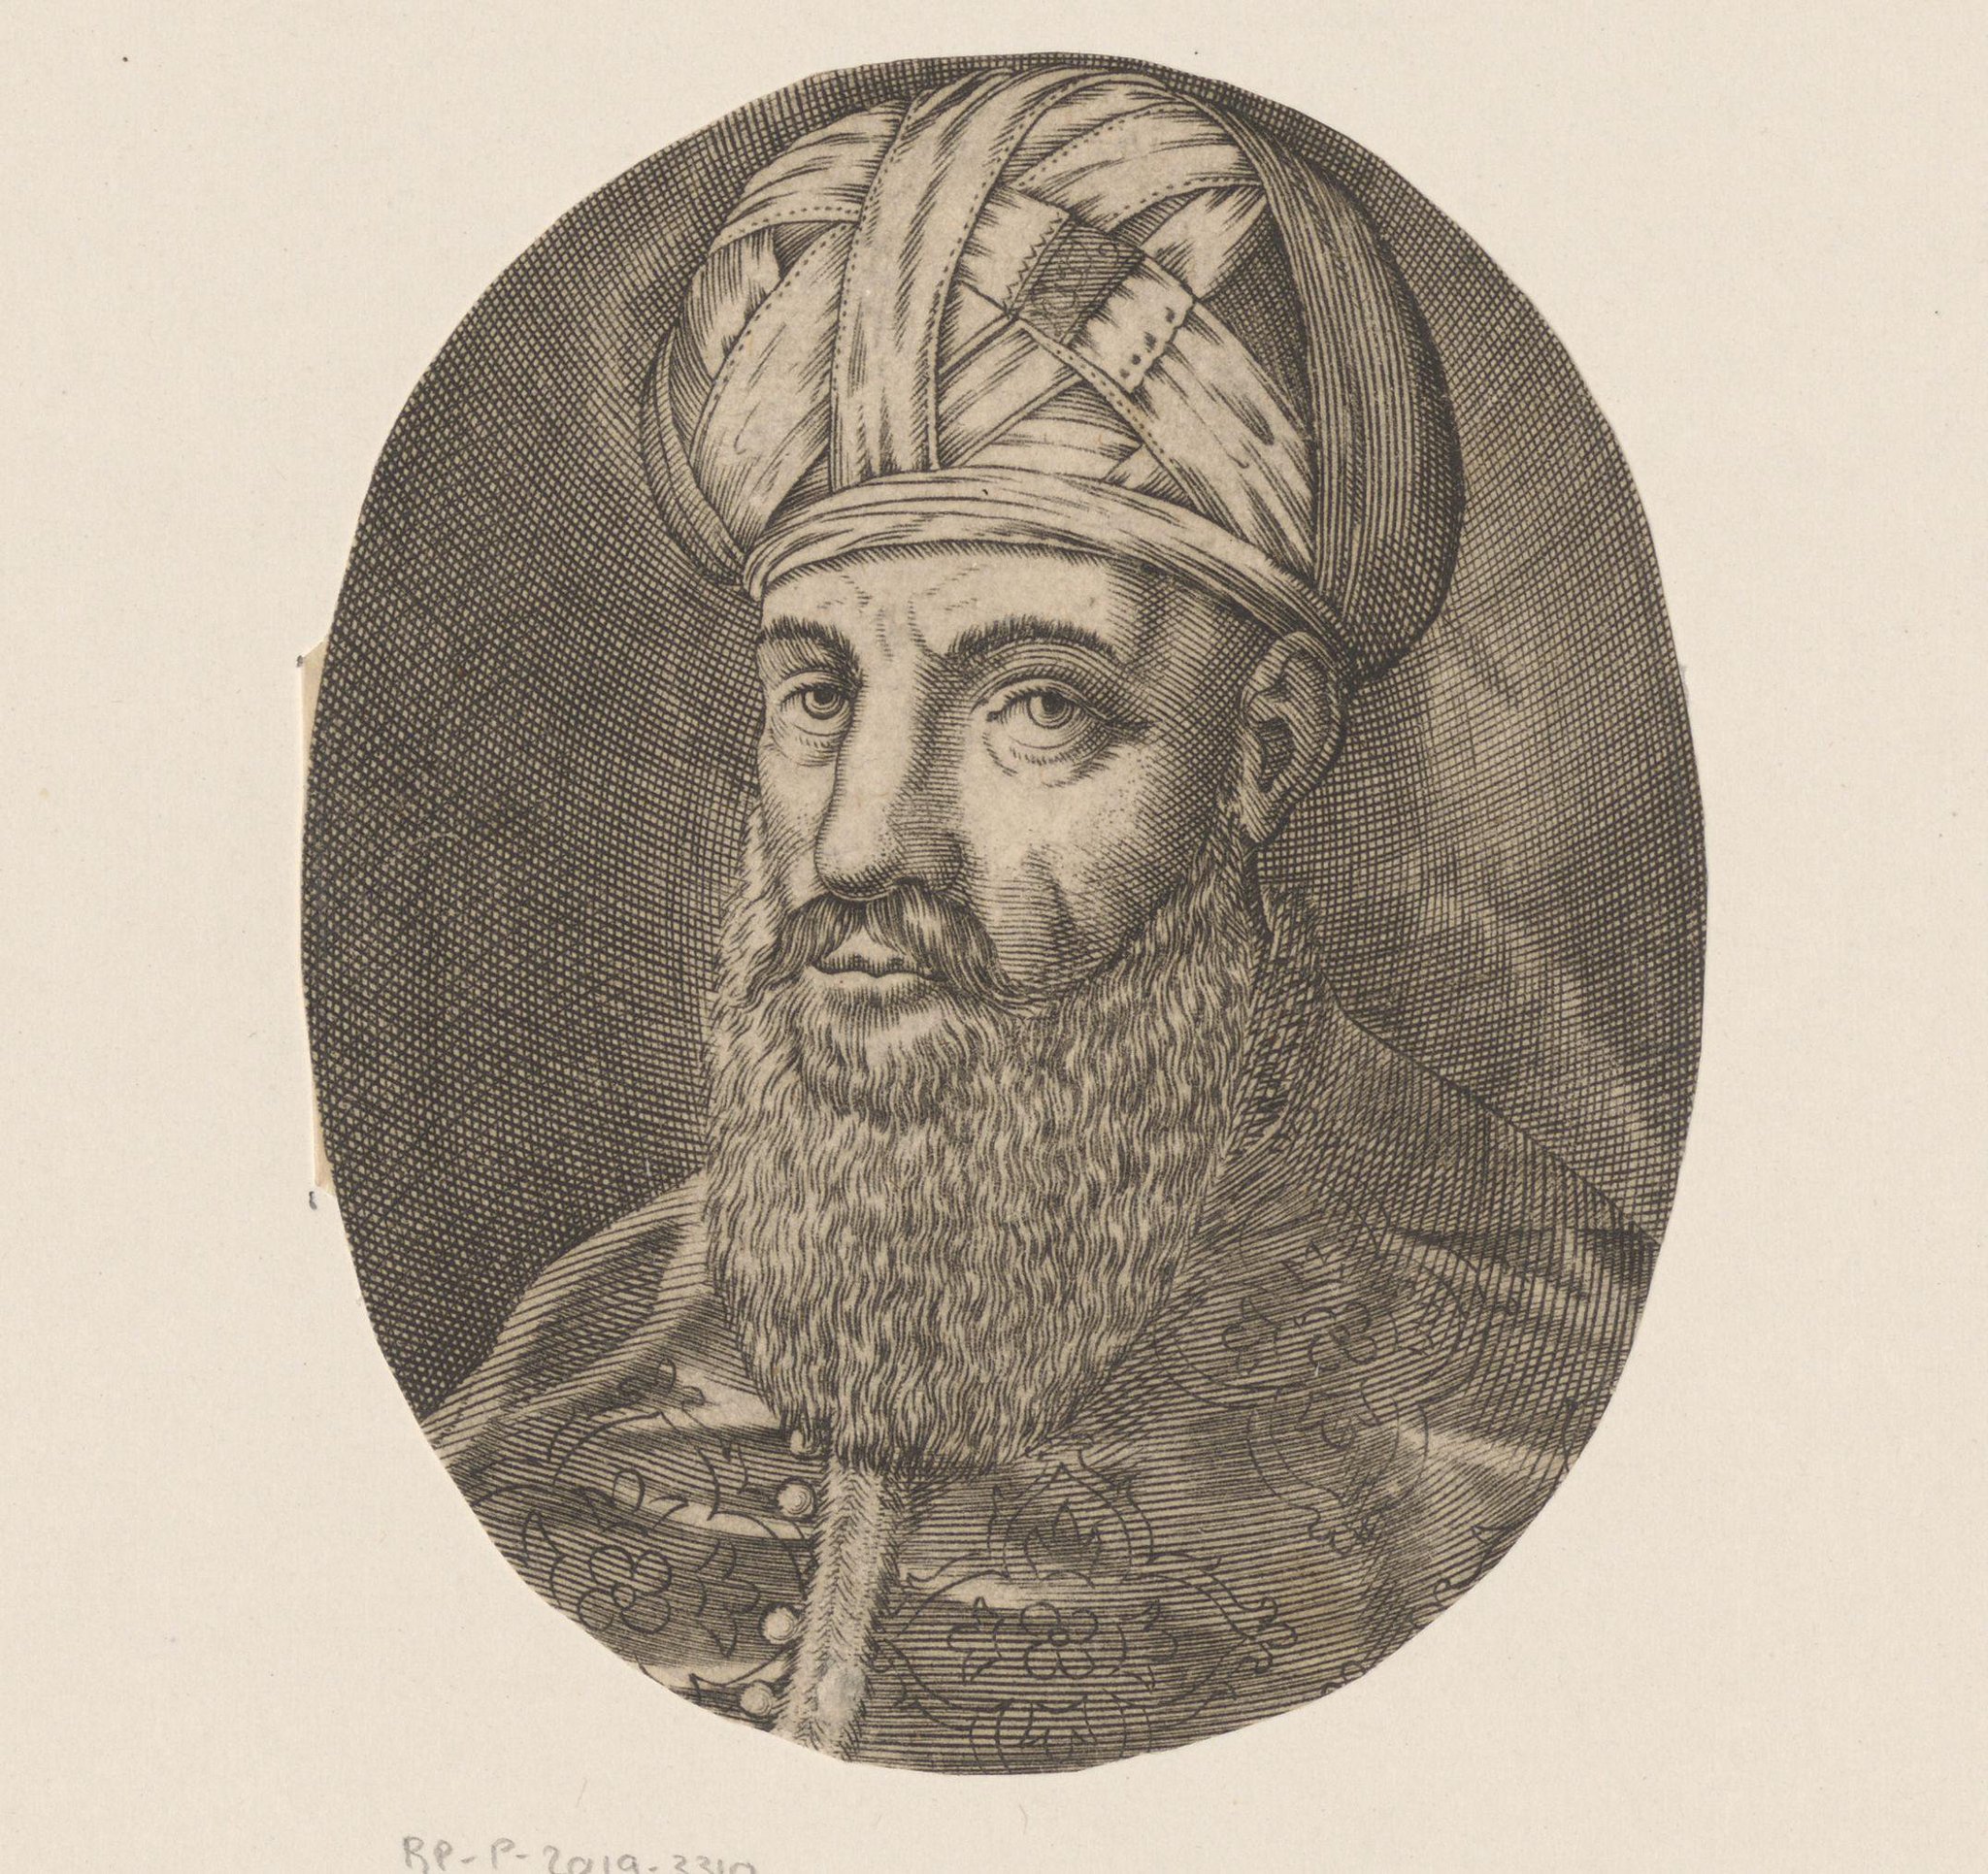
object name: book illustration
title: Portret van Ali-Bassa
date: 1665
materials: paper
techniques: engraving, etching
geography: frankfurt am main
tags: asiatic races and peoples: turks, historical persons, head-gear: turban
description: Prent uit: Oertel, Hieronymus. Ortelius redivivus et continuatus oder der Ungarischen Kriegs-Empörungen, (...). Frankfurt am Main: Daniel Fievet, 1665. p. 312.